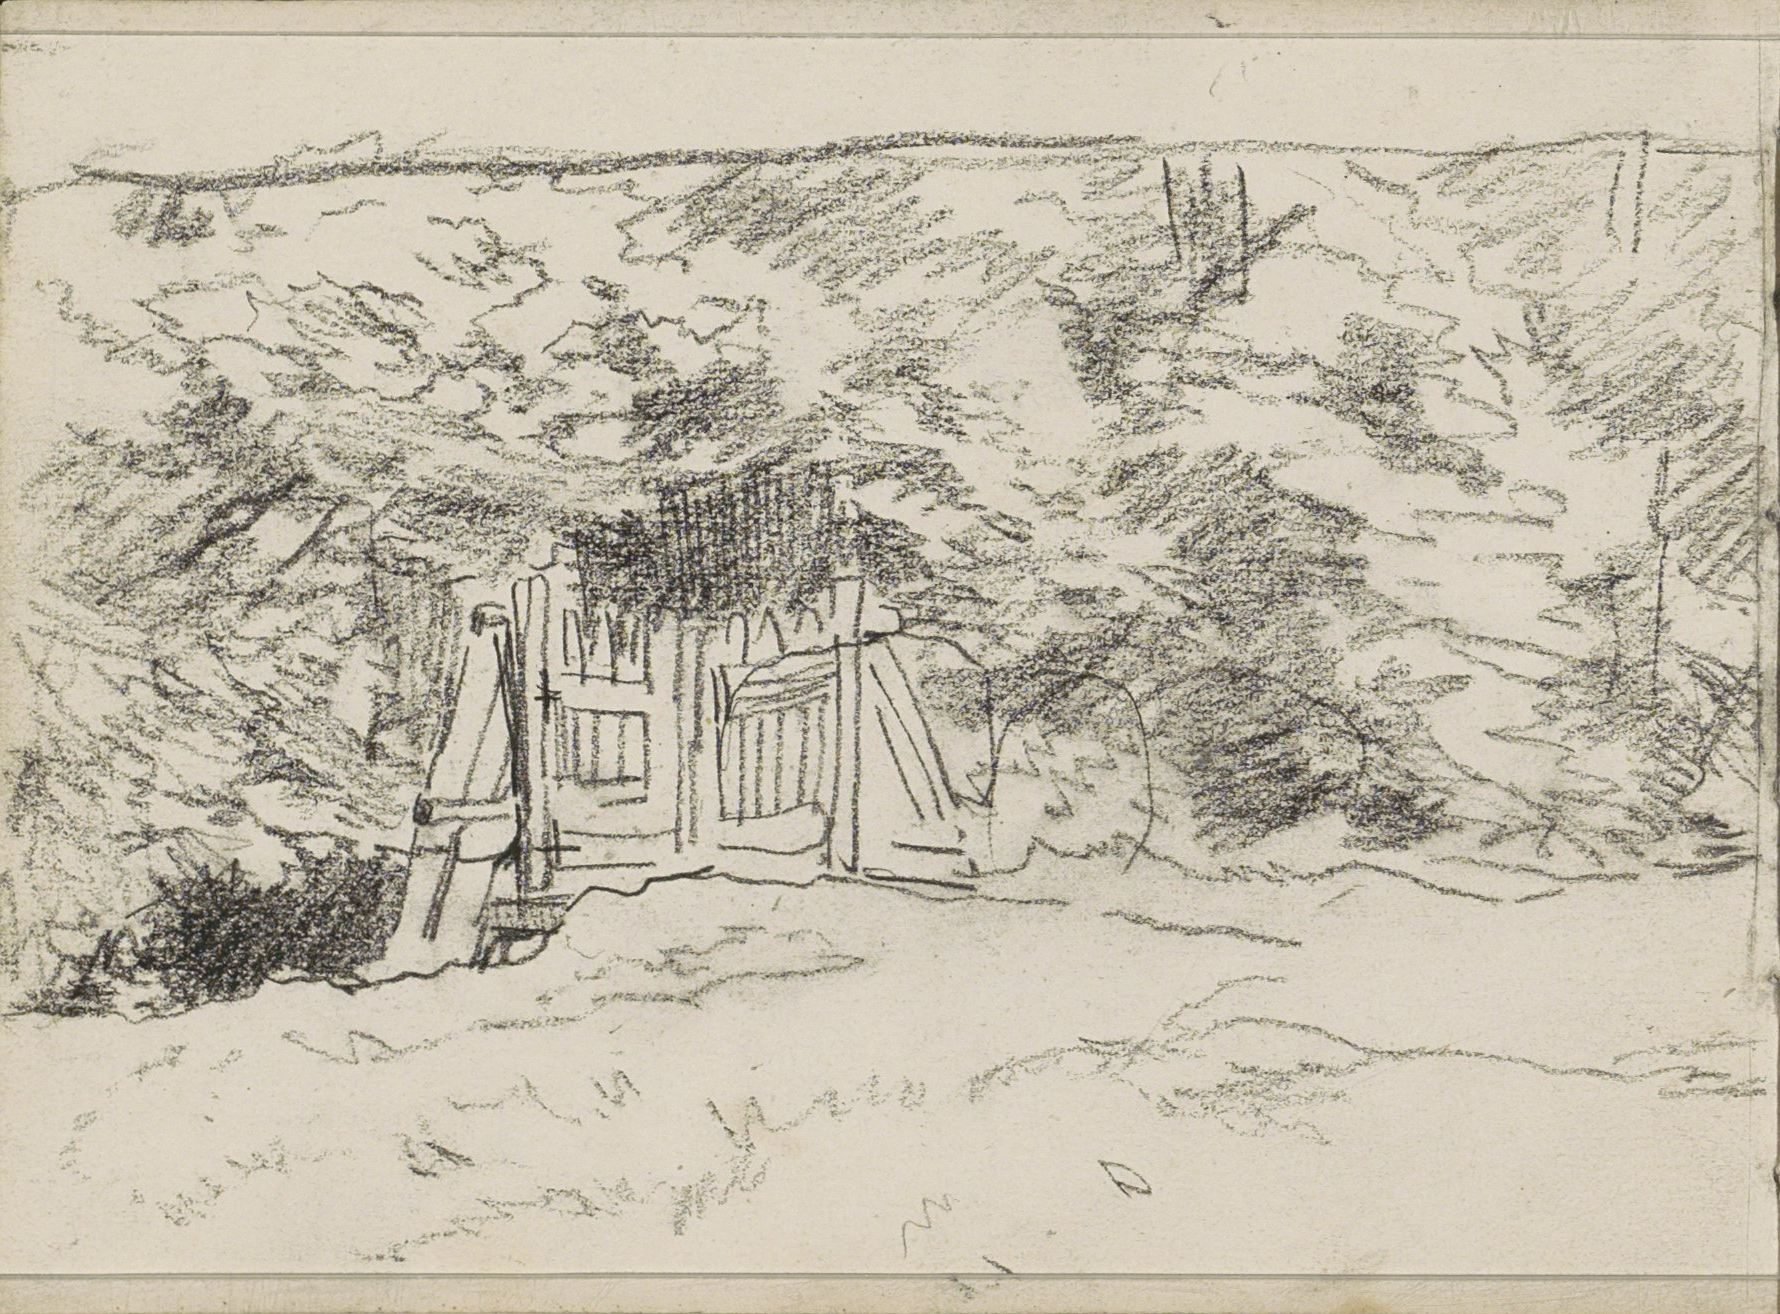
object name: sketchbook leaf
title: Hek tussen de bomen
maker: anton mauve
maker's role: draughtsman, painter, print maker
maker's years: 1838-1888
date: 1848-1888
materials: chalk, paper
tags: trees, fence, wall, paling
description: Mogelijk de ingang van een bos. Blad 13 verso uit een schetsboek met 33 bladen.